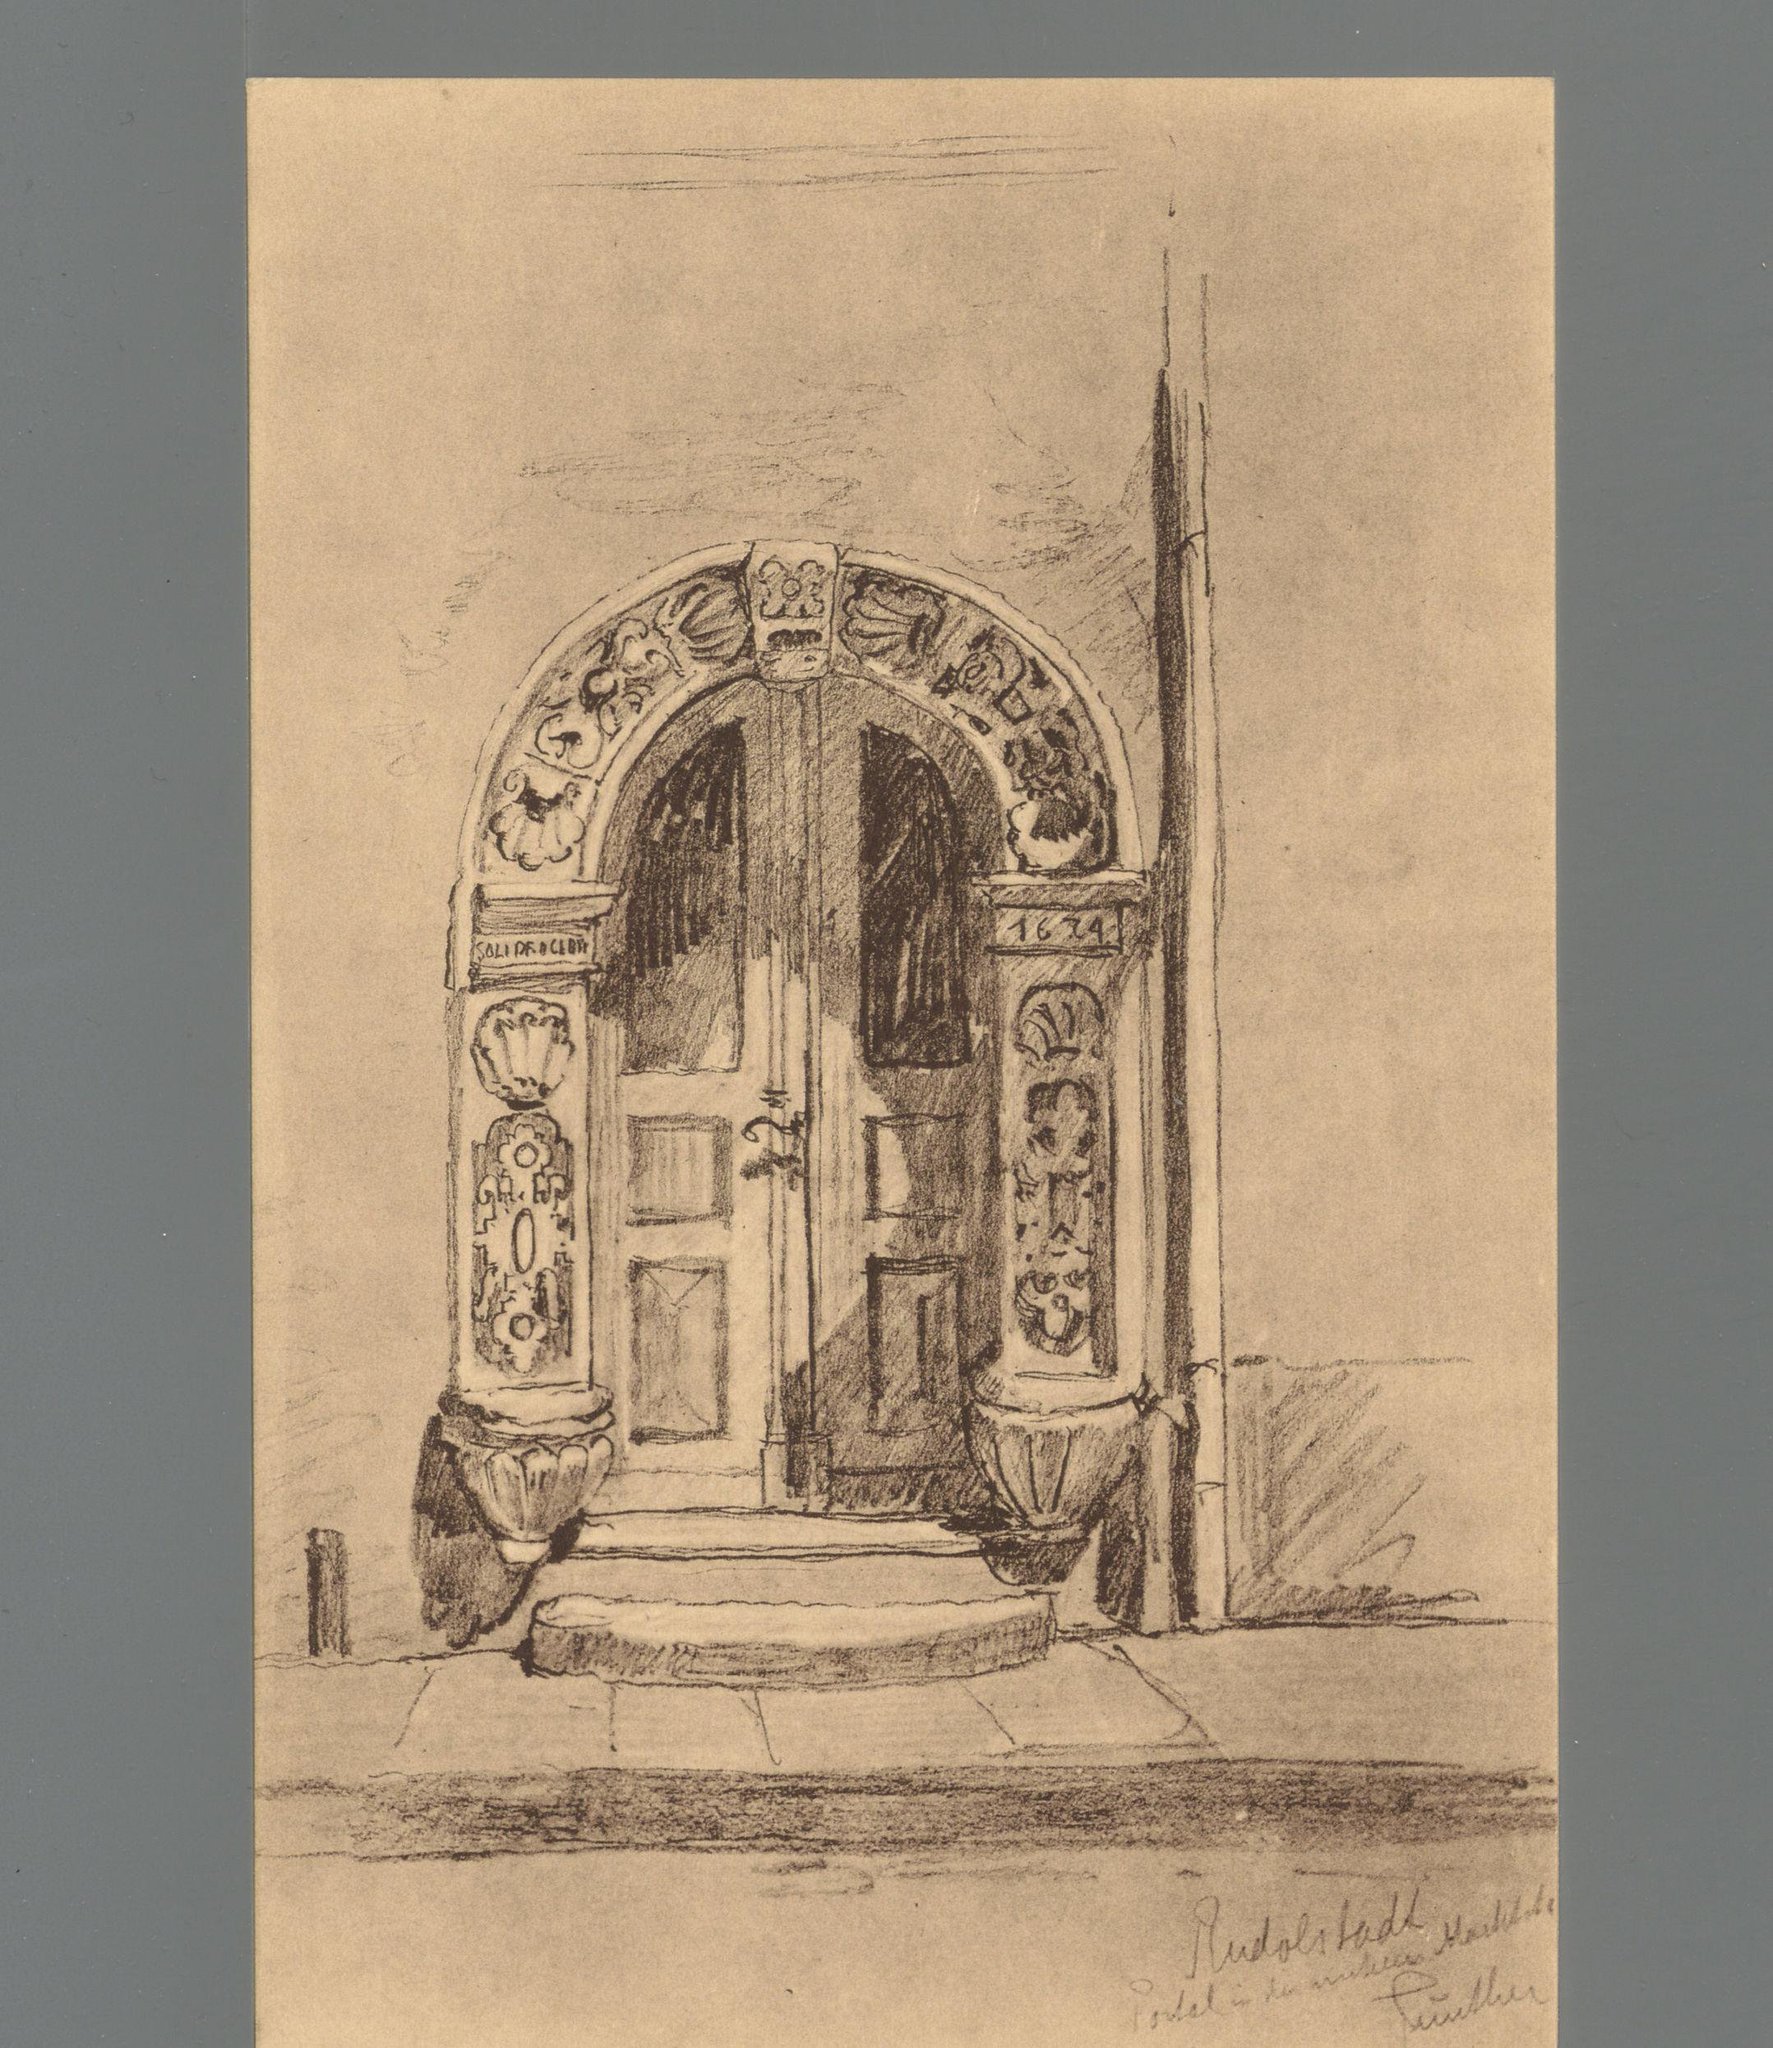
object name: photomechanical print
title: Rudolstadt. Altes Portal in der unteren Marktstrasse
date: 1915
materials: cardboard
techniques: photograph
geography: rudolstadt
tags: gate, entrance